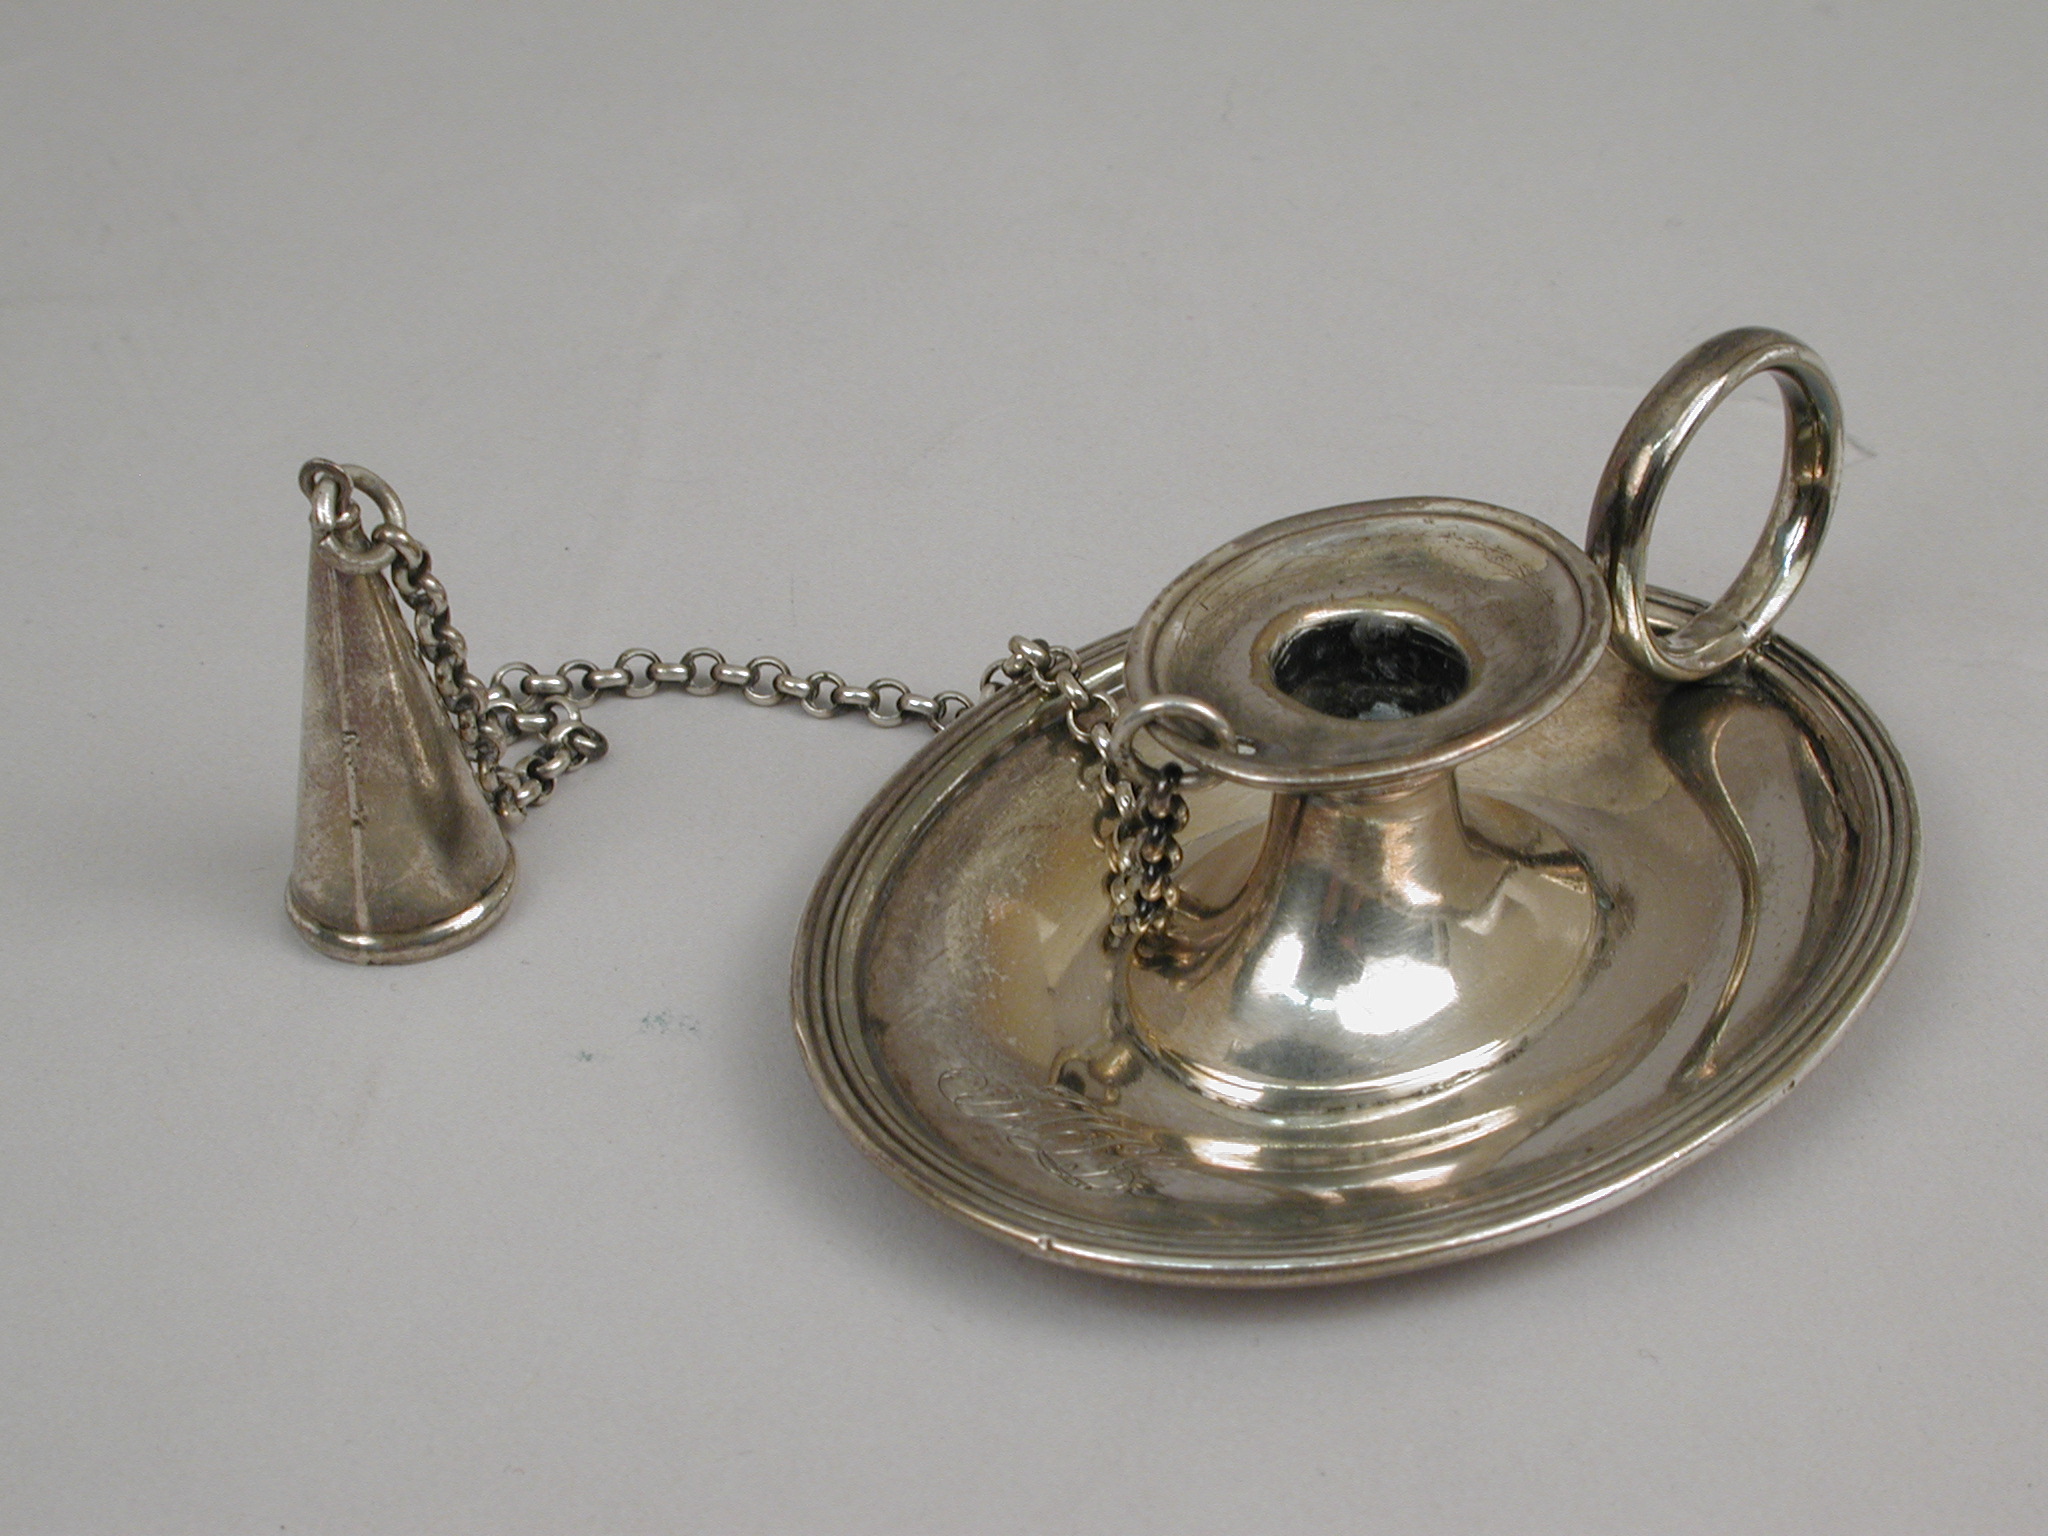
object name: taperstick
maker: nathaniel smith and company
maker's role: maker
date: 1798-1799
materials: silver